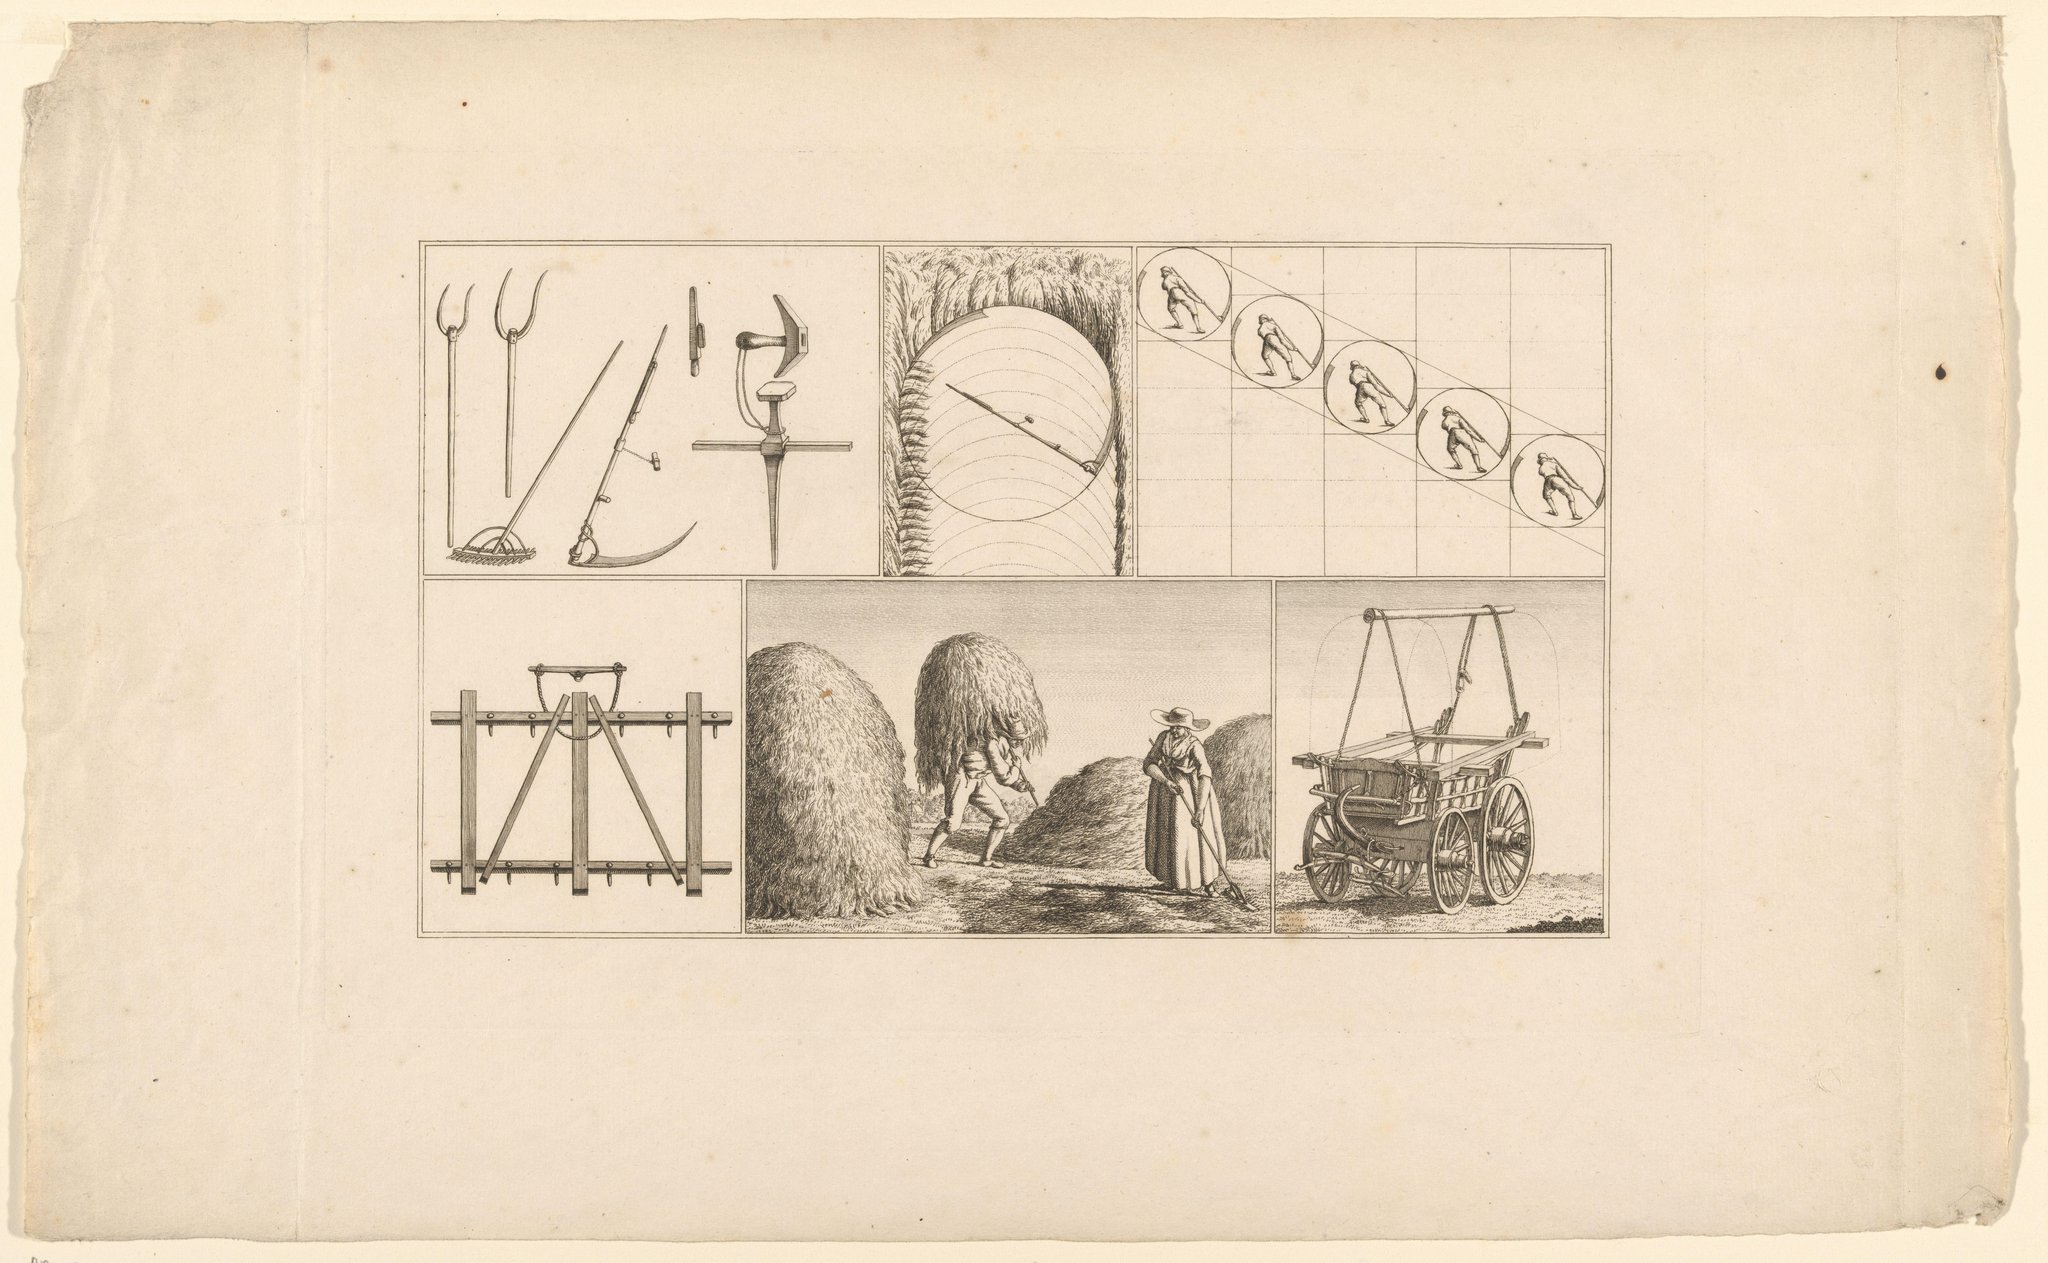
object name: print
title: Zes scènes met betrekking tot de oogst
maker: Anonymous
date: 1700-1799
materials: paper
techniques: etching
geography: netherlands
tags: agricultural implements: scythe, harvest, agricultural implements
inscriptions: collector's mark: Lugt 2228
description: Maakt mogelijk deel uit van een onbekende serie over landbouw en landbouwwerktuigen.